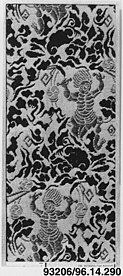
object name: piece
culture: japanese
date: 1701-1900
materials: silk